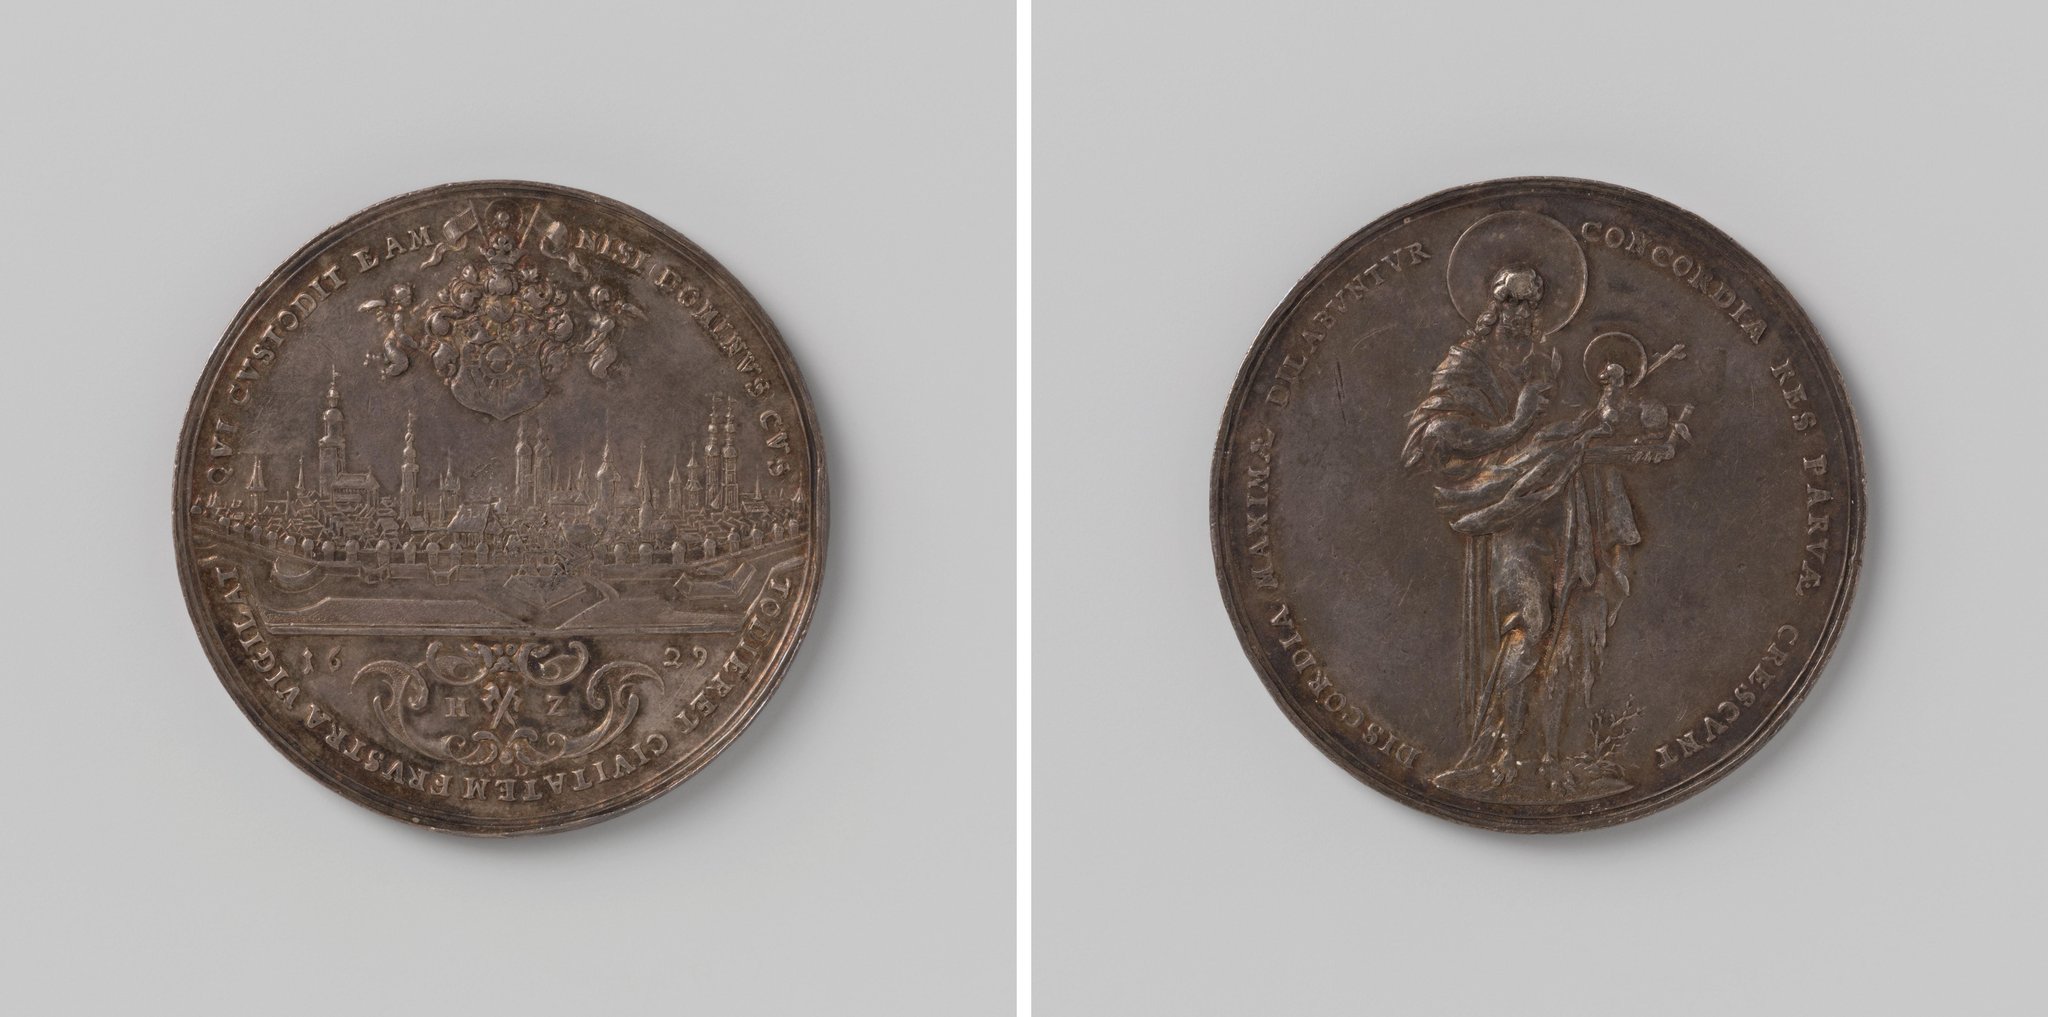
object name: history medal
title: Stad Augsburg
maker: sebastian dadler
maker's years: 1586-1657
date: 1629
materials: silver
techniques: striking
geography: dresden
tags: augsburg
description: Zilveren penning. Voorzijde: gezicht op stad Augsburg onder wapenschild, geflankeerd door twee engeltjes met omschrift. Keerzijde: Johannes de Doper met aureool houdt lam met aureool, bijbel en kruis in hand binnen omschrift